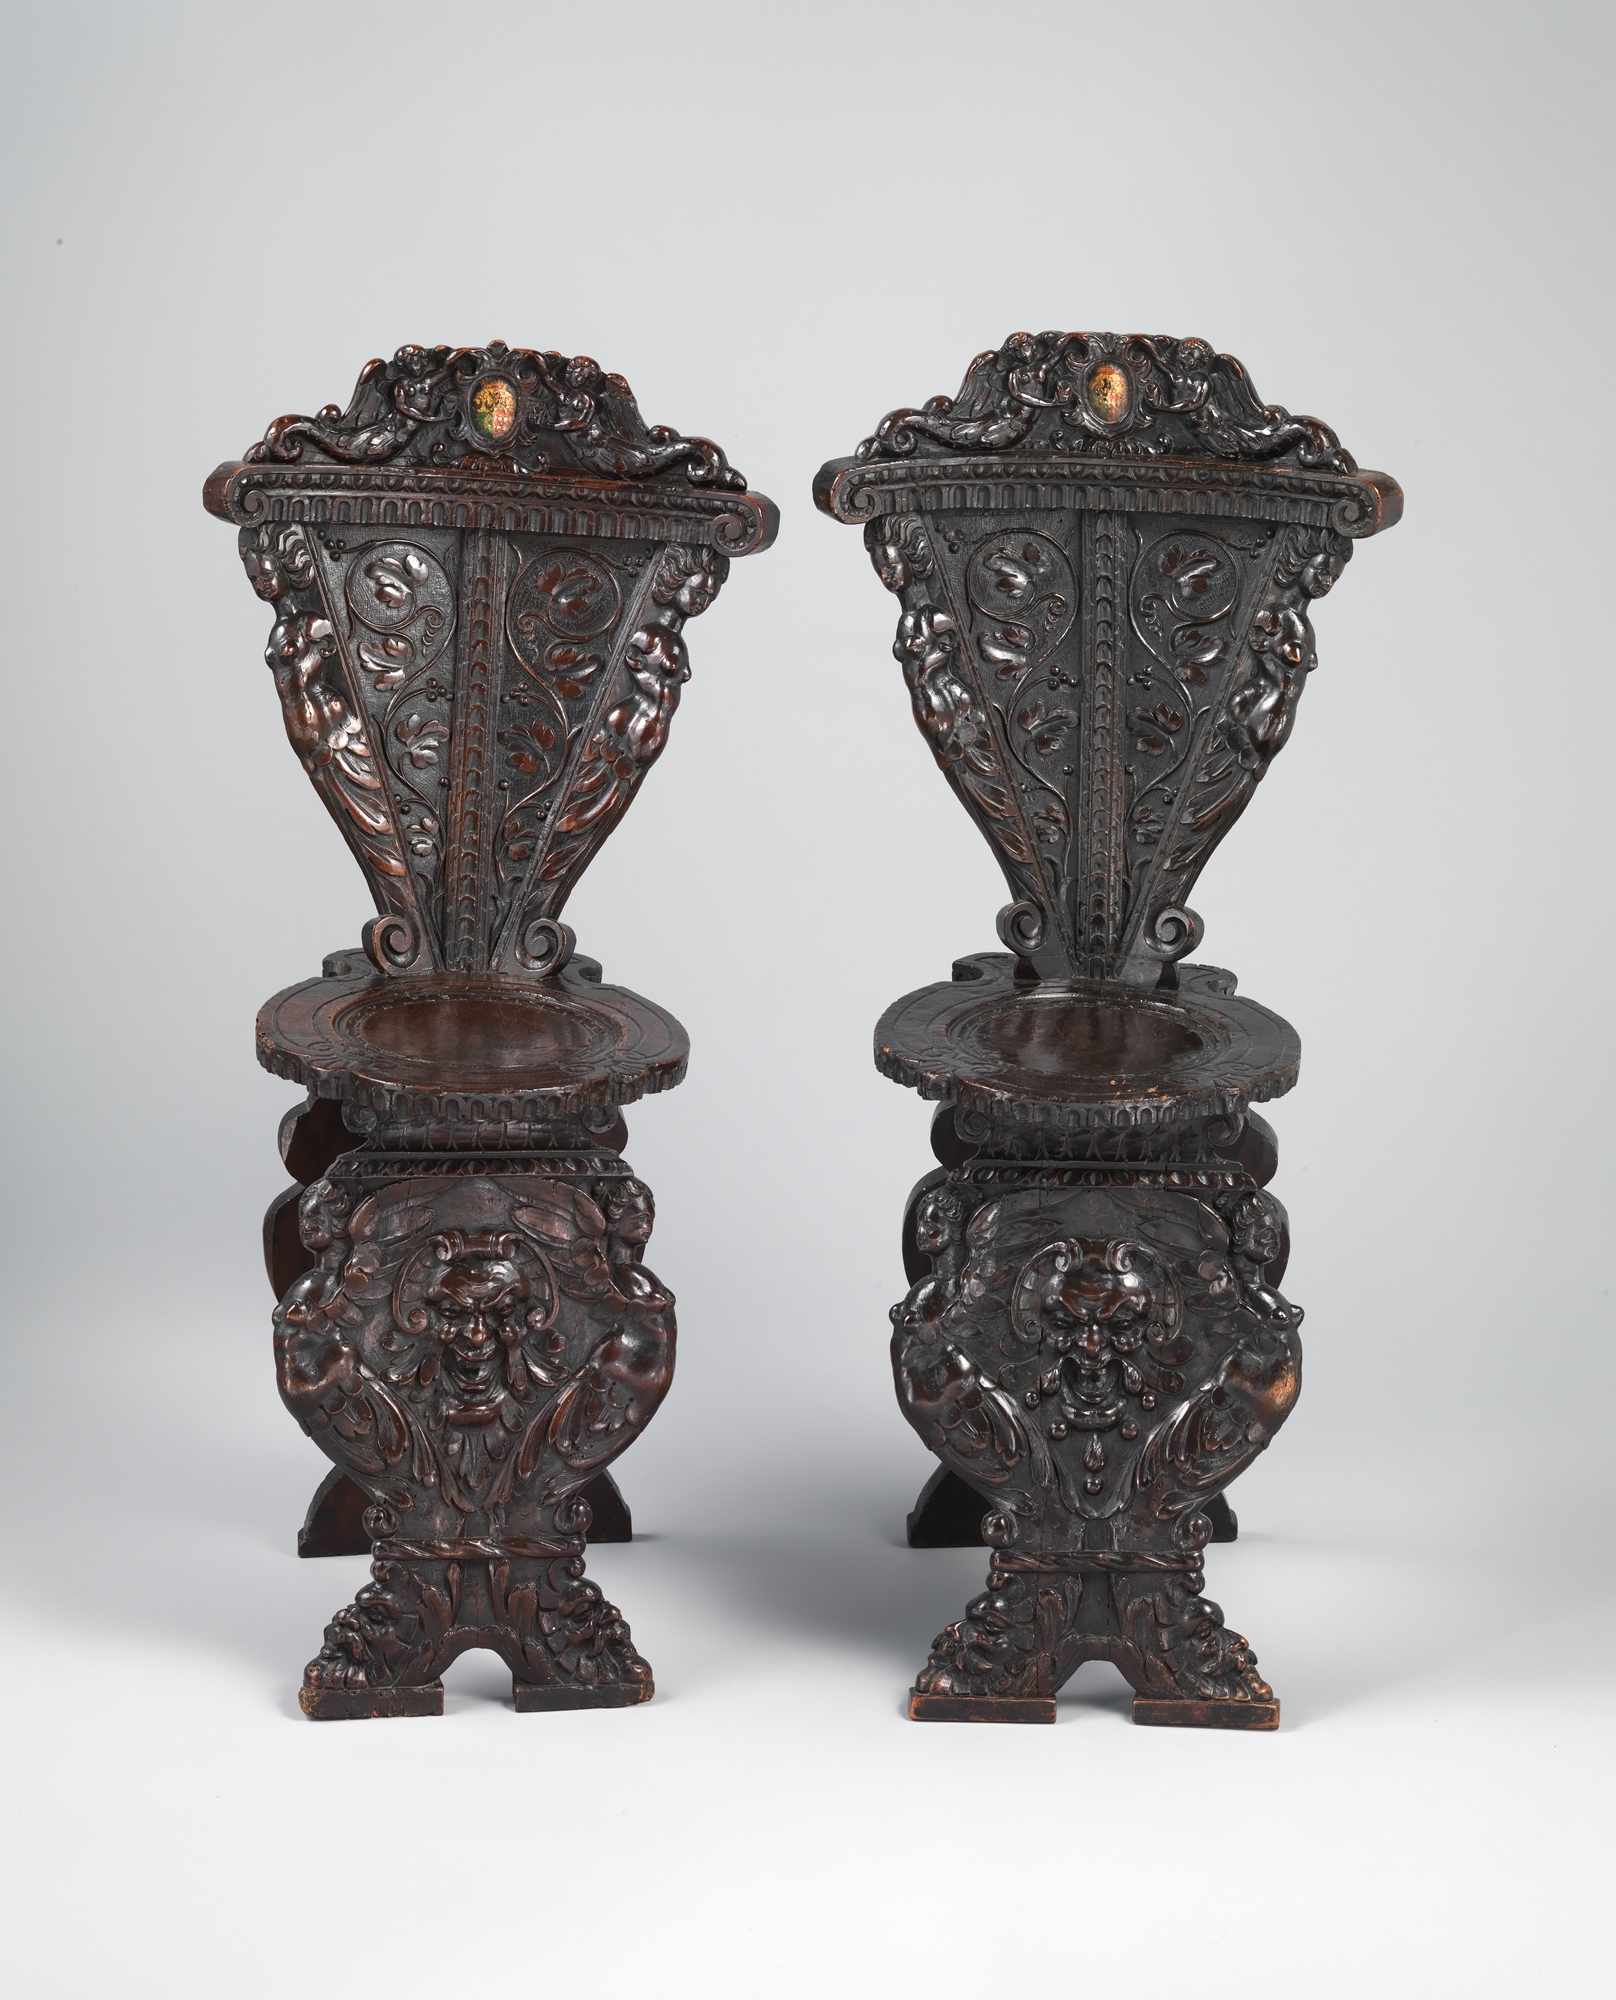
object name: sgabello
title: Sgabello (one of a pair)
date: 1575-1600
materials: wood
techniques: carving, painting